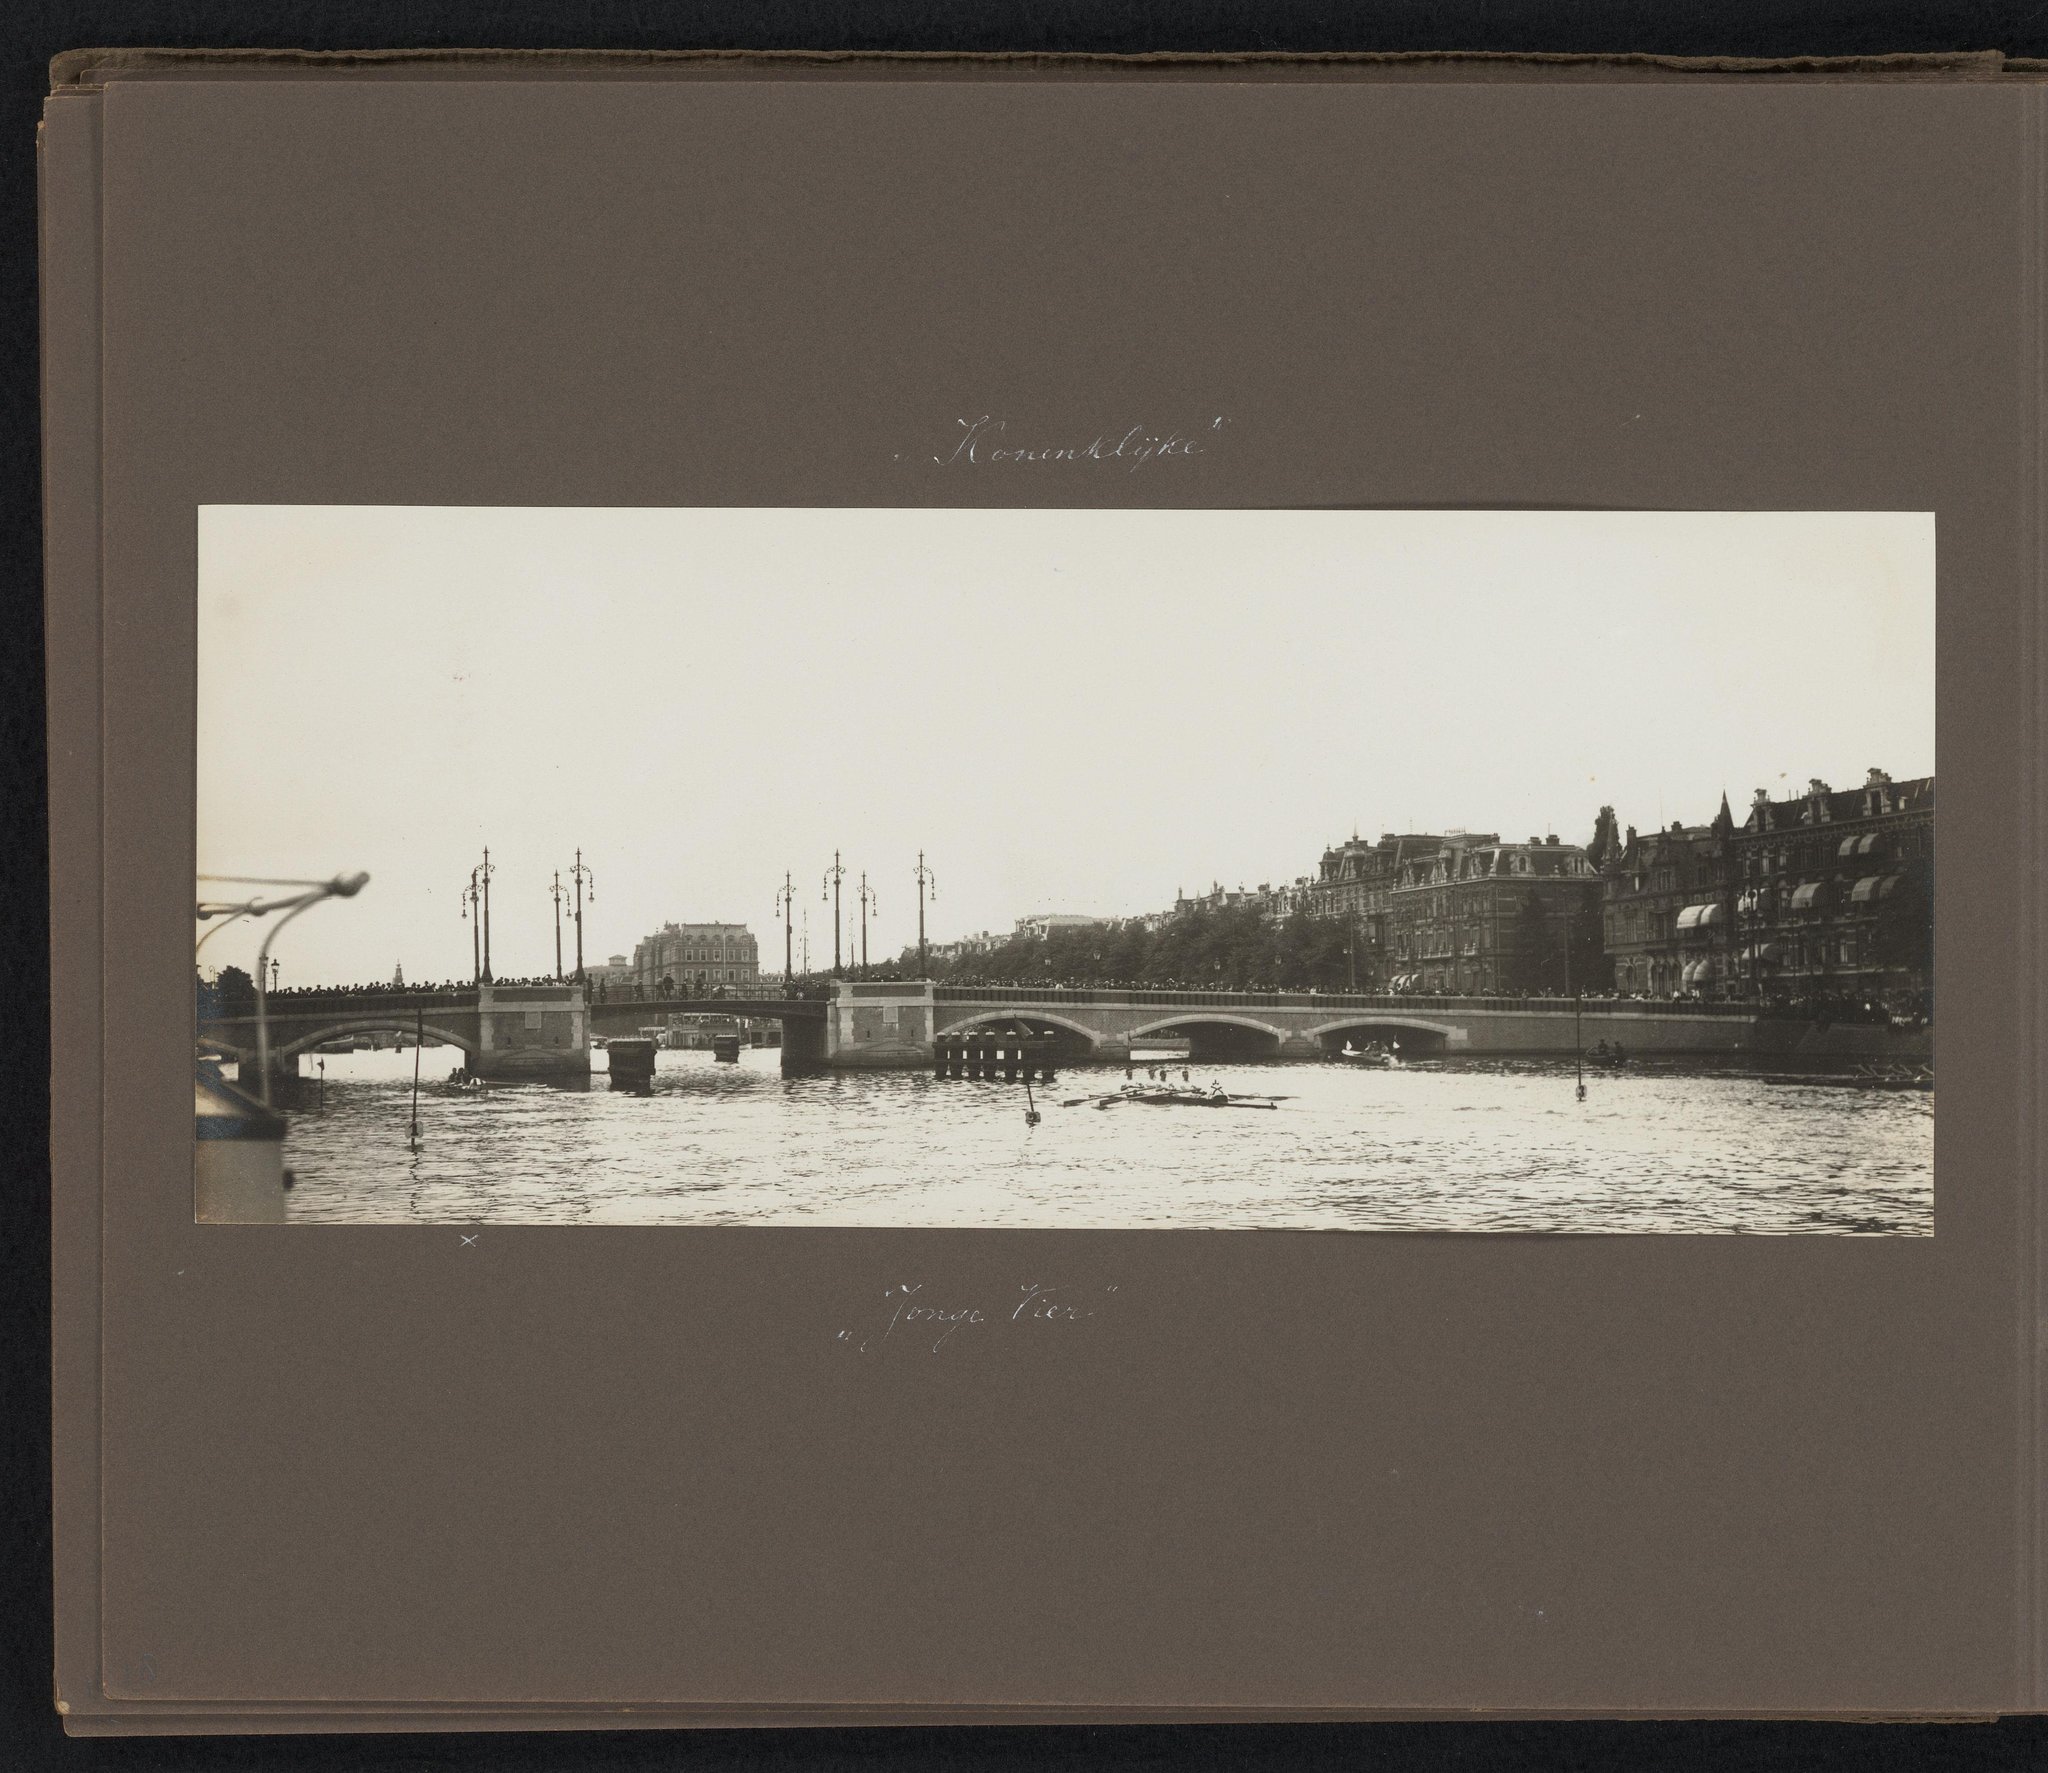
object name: album leaf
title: Jonge Vier in actie op de Amstel tijdens de Koninklijke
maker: Anonymous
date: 1915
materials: paper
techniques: gelatin silver print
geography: amsterdam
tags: rowing facing backward, pulling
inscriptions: caption: ‘"Jonge Vier"’